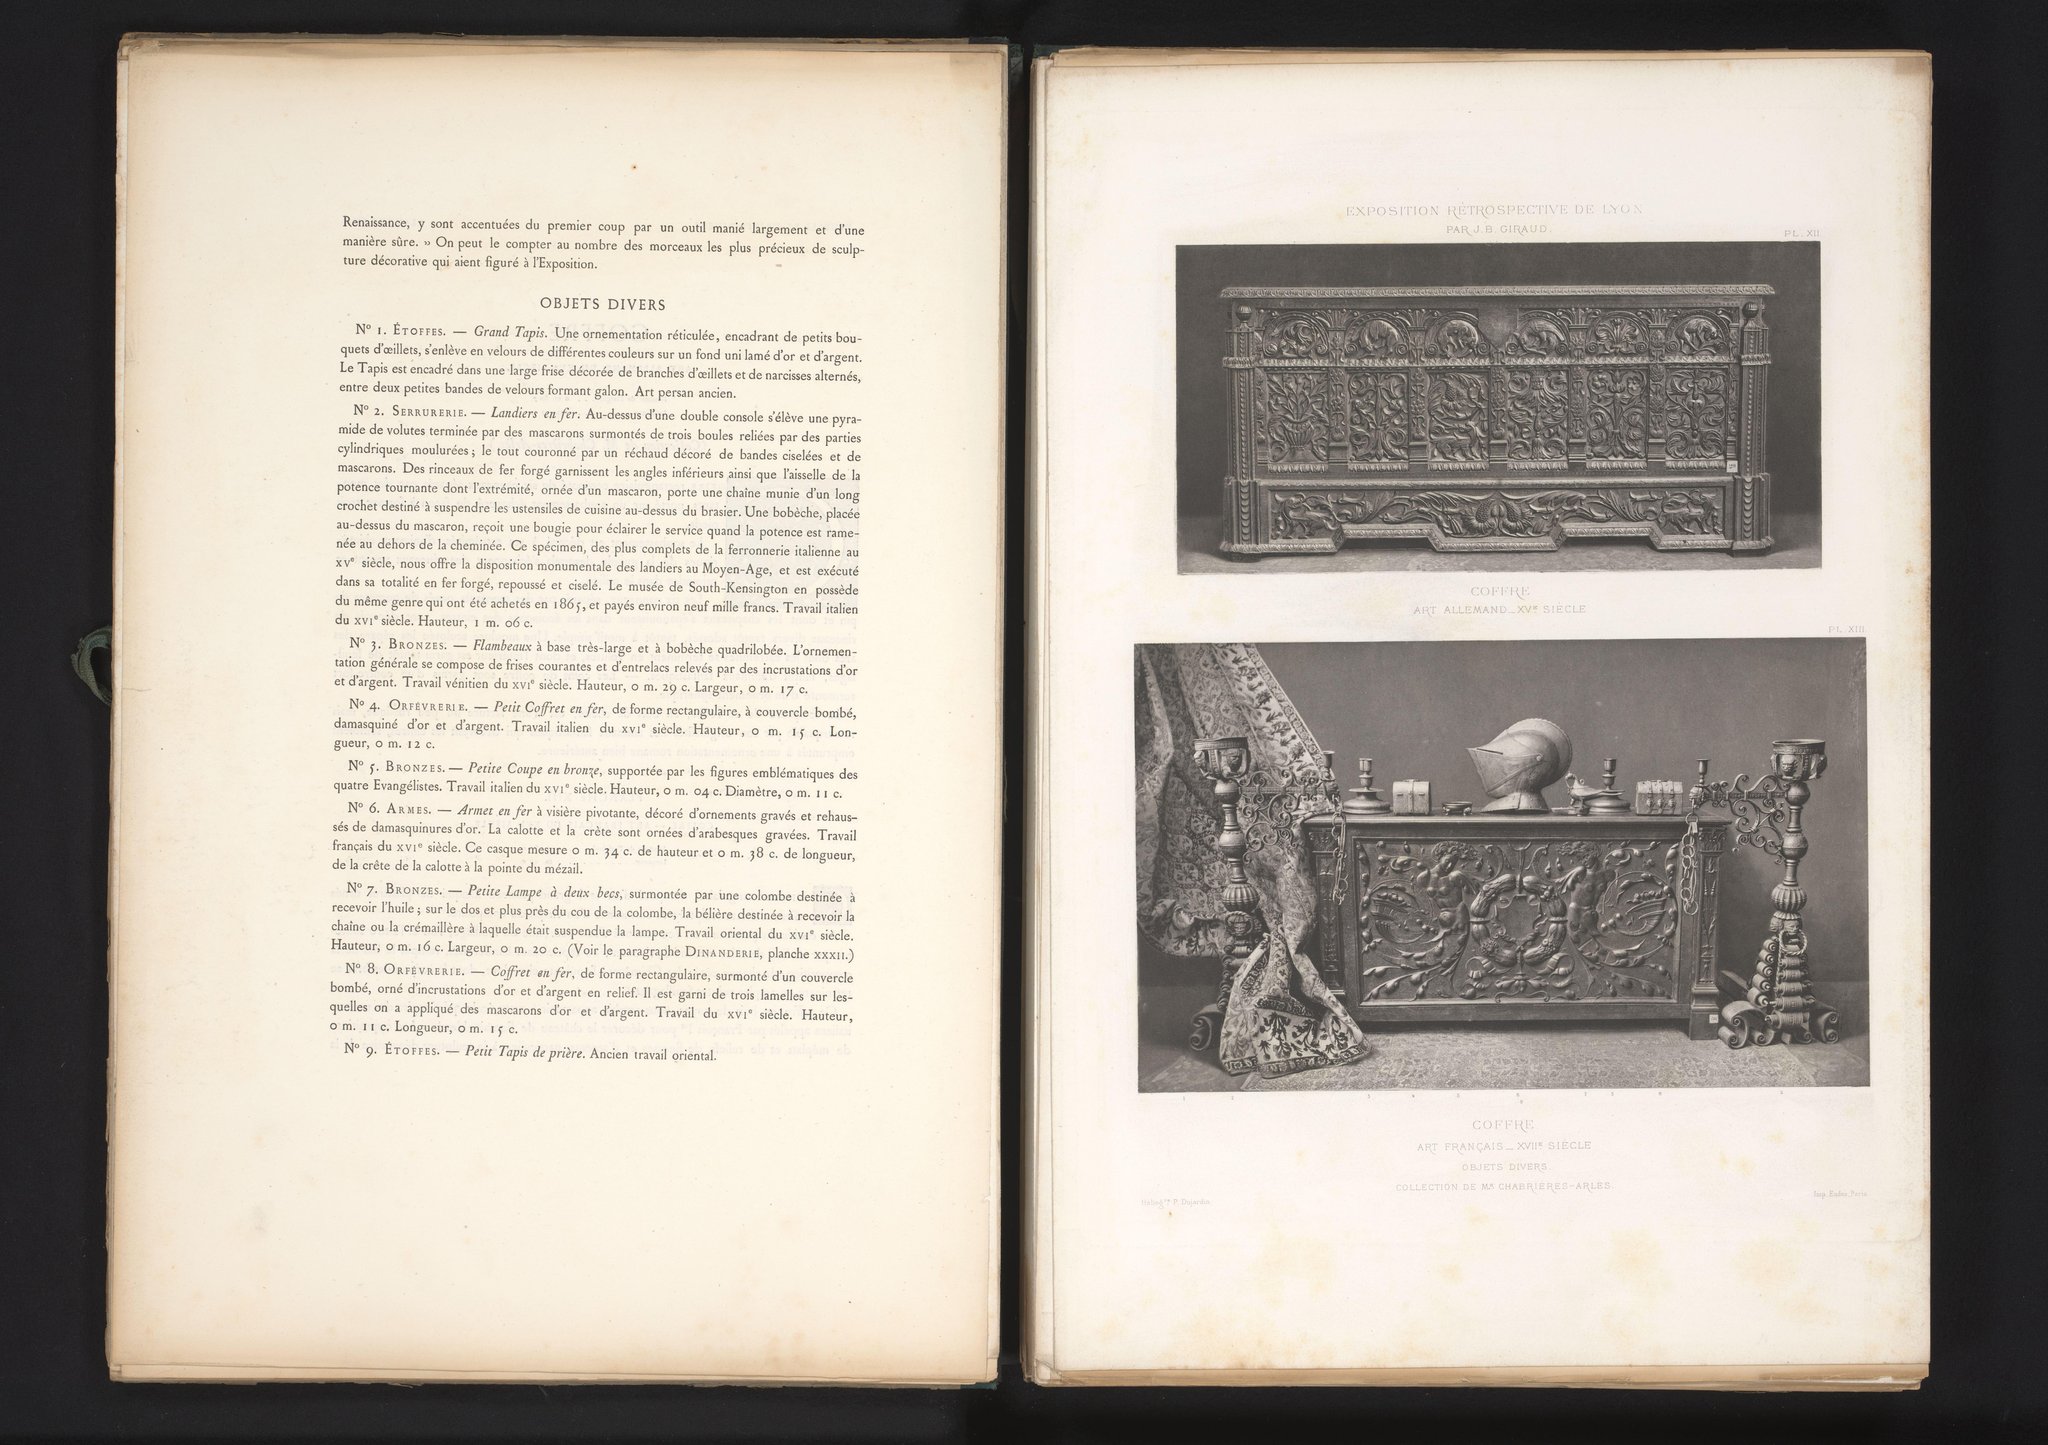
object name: photomechanical print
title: 15de-eeuwse Duitse koffer van hout en een 17de-eeuwse Franse koffer van hout, op de Exposition Rétrospective van 1877 in Lyon, Frankrijk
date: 1877-1878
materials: paper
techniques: photoaquatint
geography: lyon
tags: chest, coffer (+ wood and other phytogenic material), lyon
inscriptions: number: ‘PL. XIII.’, number: ‘PL. XII.’, inscription: ‘EXPOSITION RÉTROSPECTIVE DE LYON/ PAR J. B. GIRAUD.’, inscription: ‘COFFRE/ ART ALLEMAND_XVe SIÈCLE’, inscription: ‘COFFRE/ ART FRANÇAIS_XVIIe SIÈCLE/ OBJETS DIVERS/ COLLECTION DE Mr CHABRIÈRES-ARLES.’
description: Deze prenten maken deel uit van een omslag met 79 prenten op 54 bladen en 65 tekstbladen.